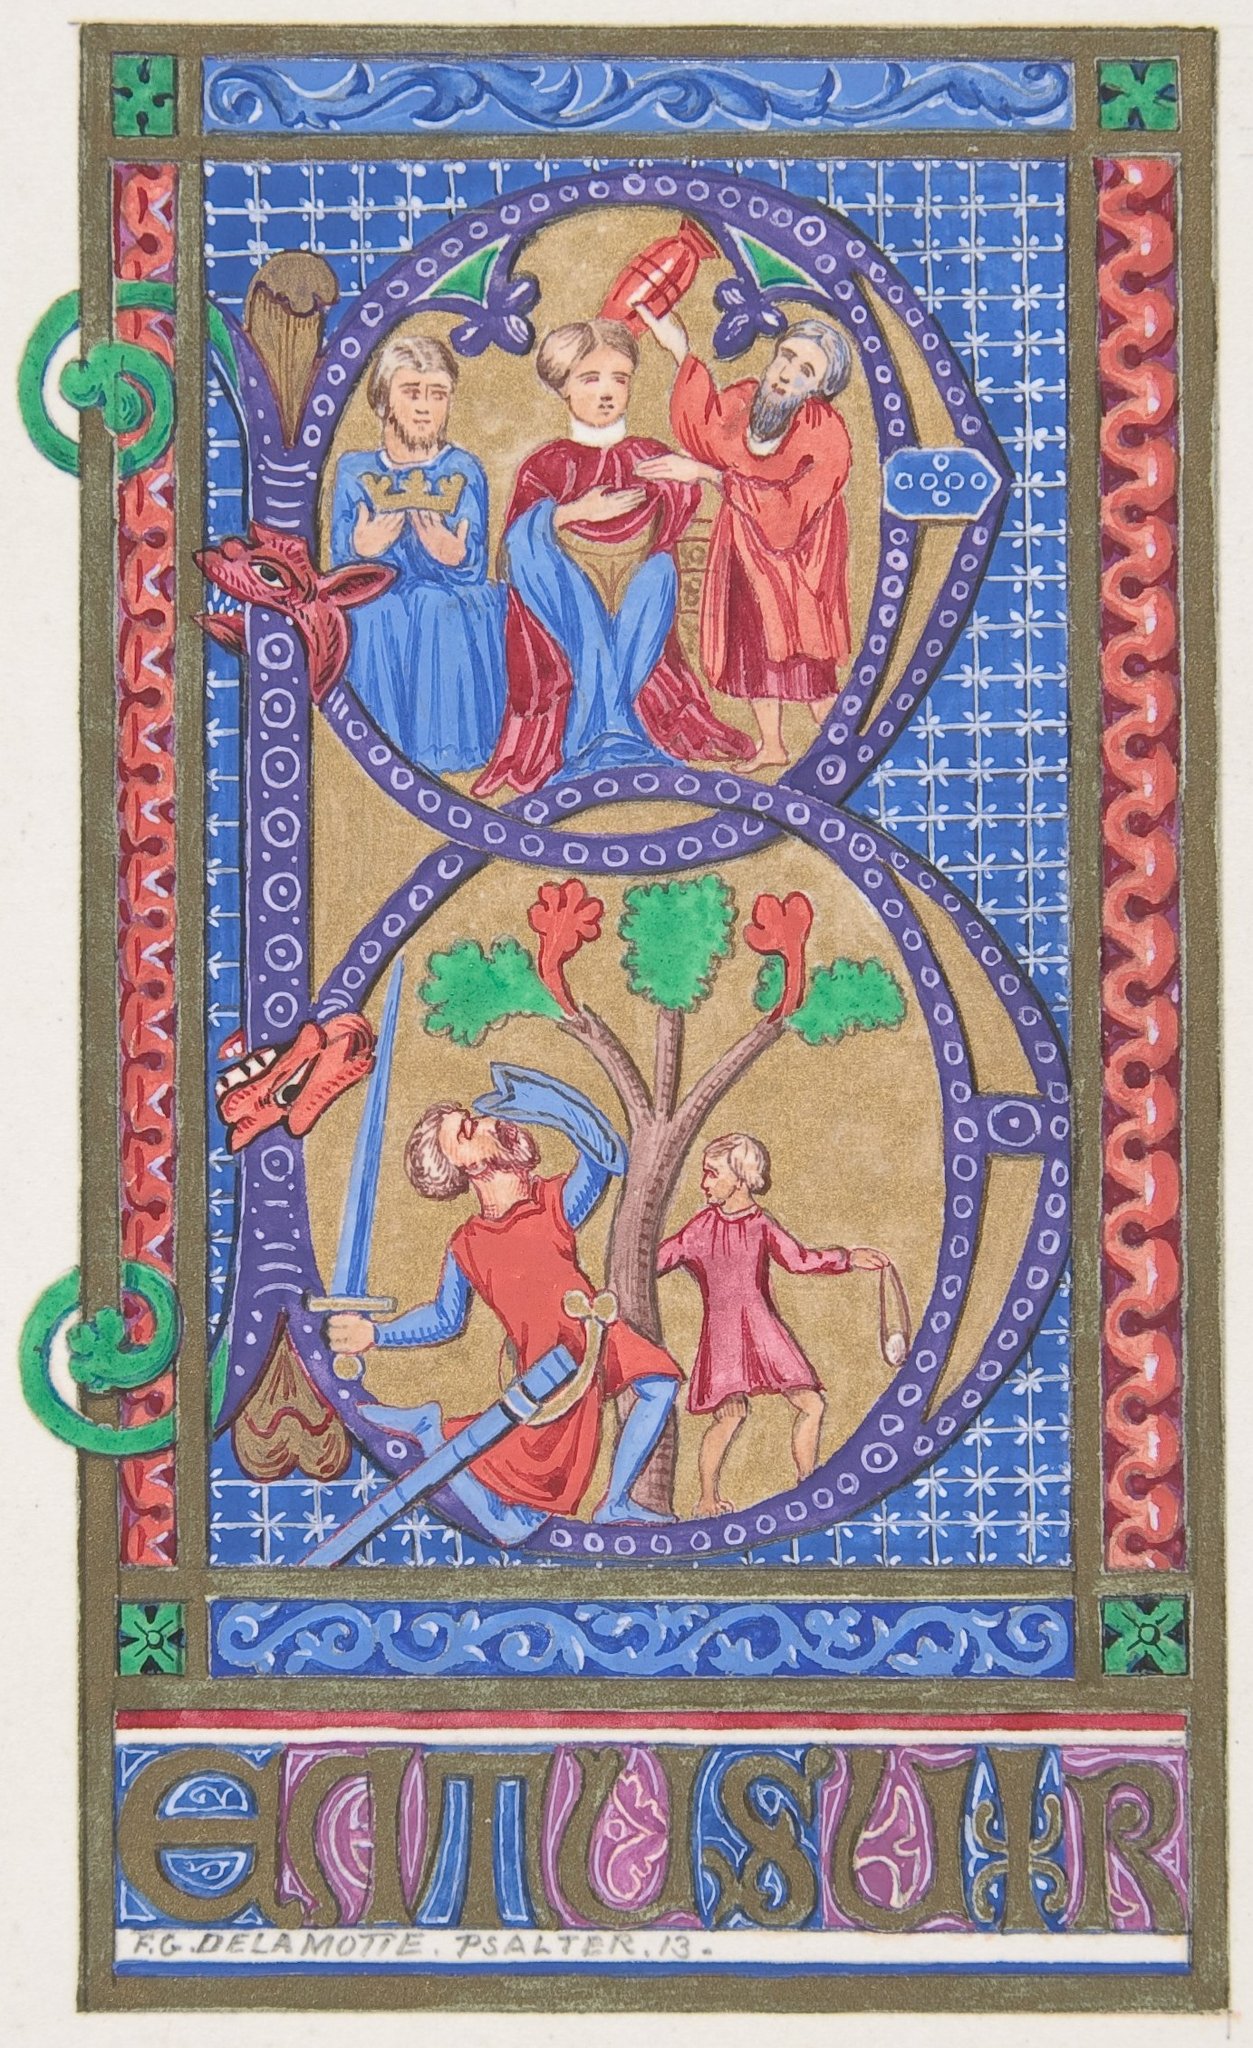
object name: drawing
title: Illuminated Initial "B"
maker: freeman gage delamotte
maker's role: artist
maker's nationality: british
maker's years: 1813-1862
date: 1830-1862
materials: gold, gouache, graphite, watercolor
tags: boys,men,trees